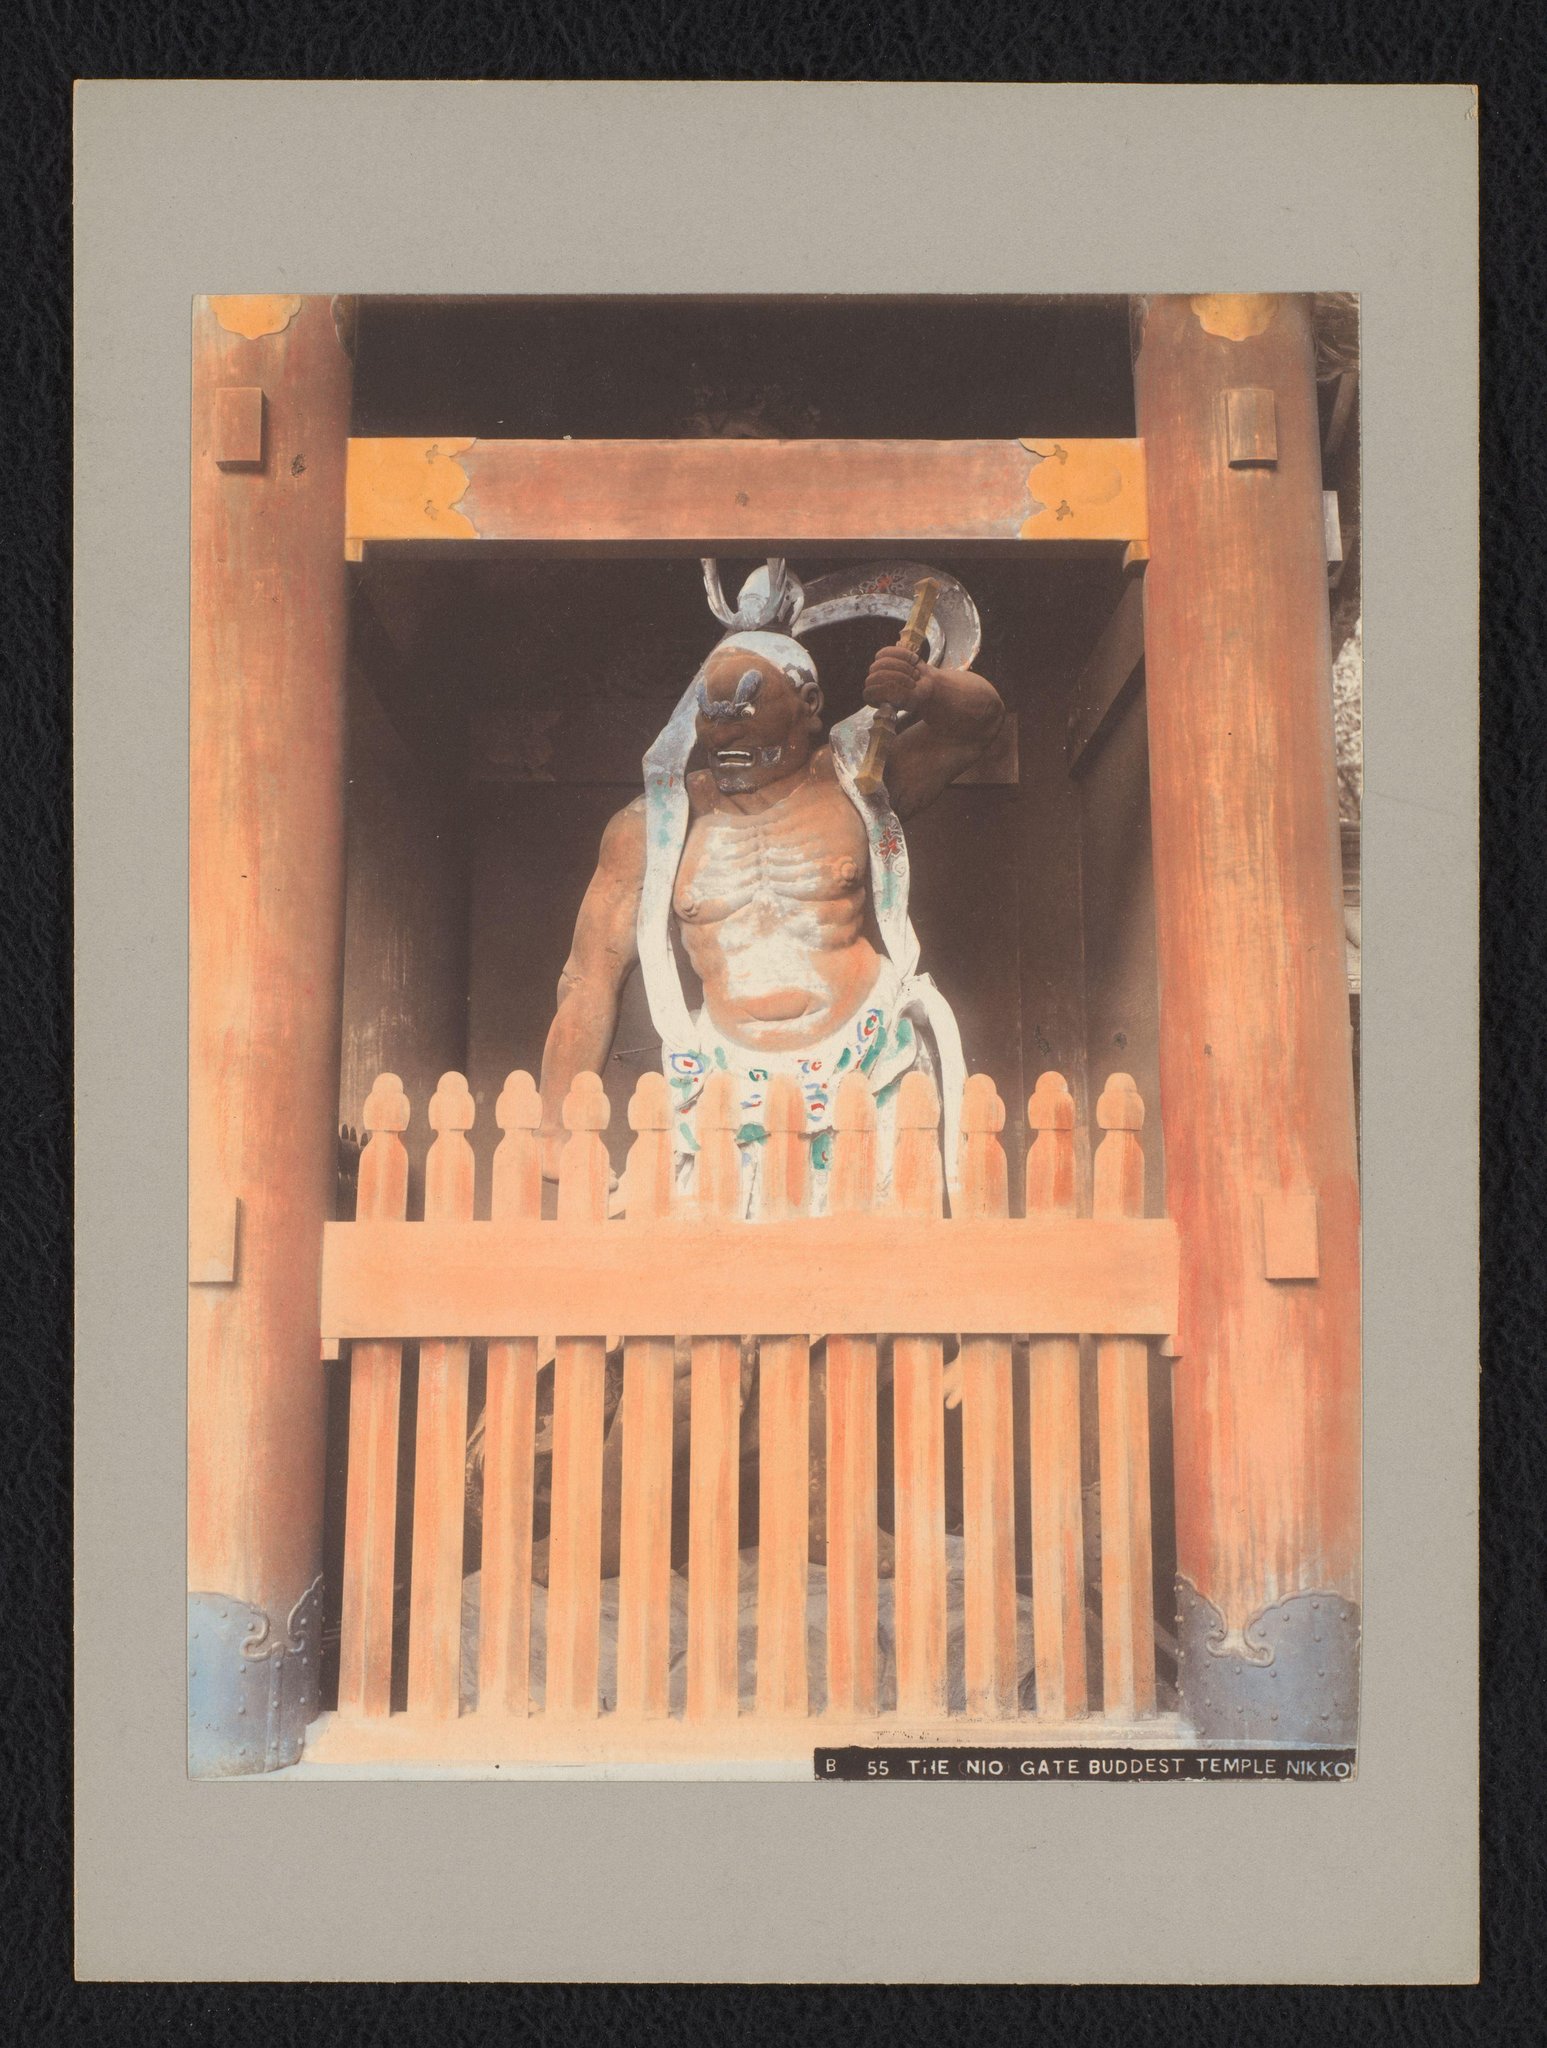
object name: photograph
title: Beeld in de Nio-poort, Nikko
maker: Anonymous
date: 1895-1915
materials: cardboard, photographic support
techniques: salted paper print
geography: nikko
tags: nikko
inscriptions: number: ‘30.’